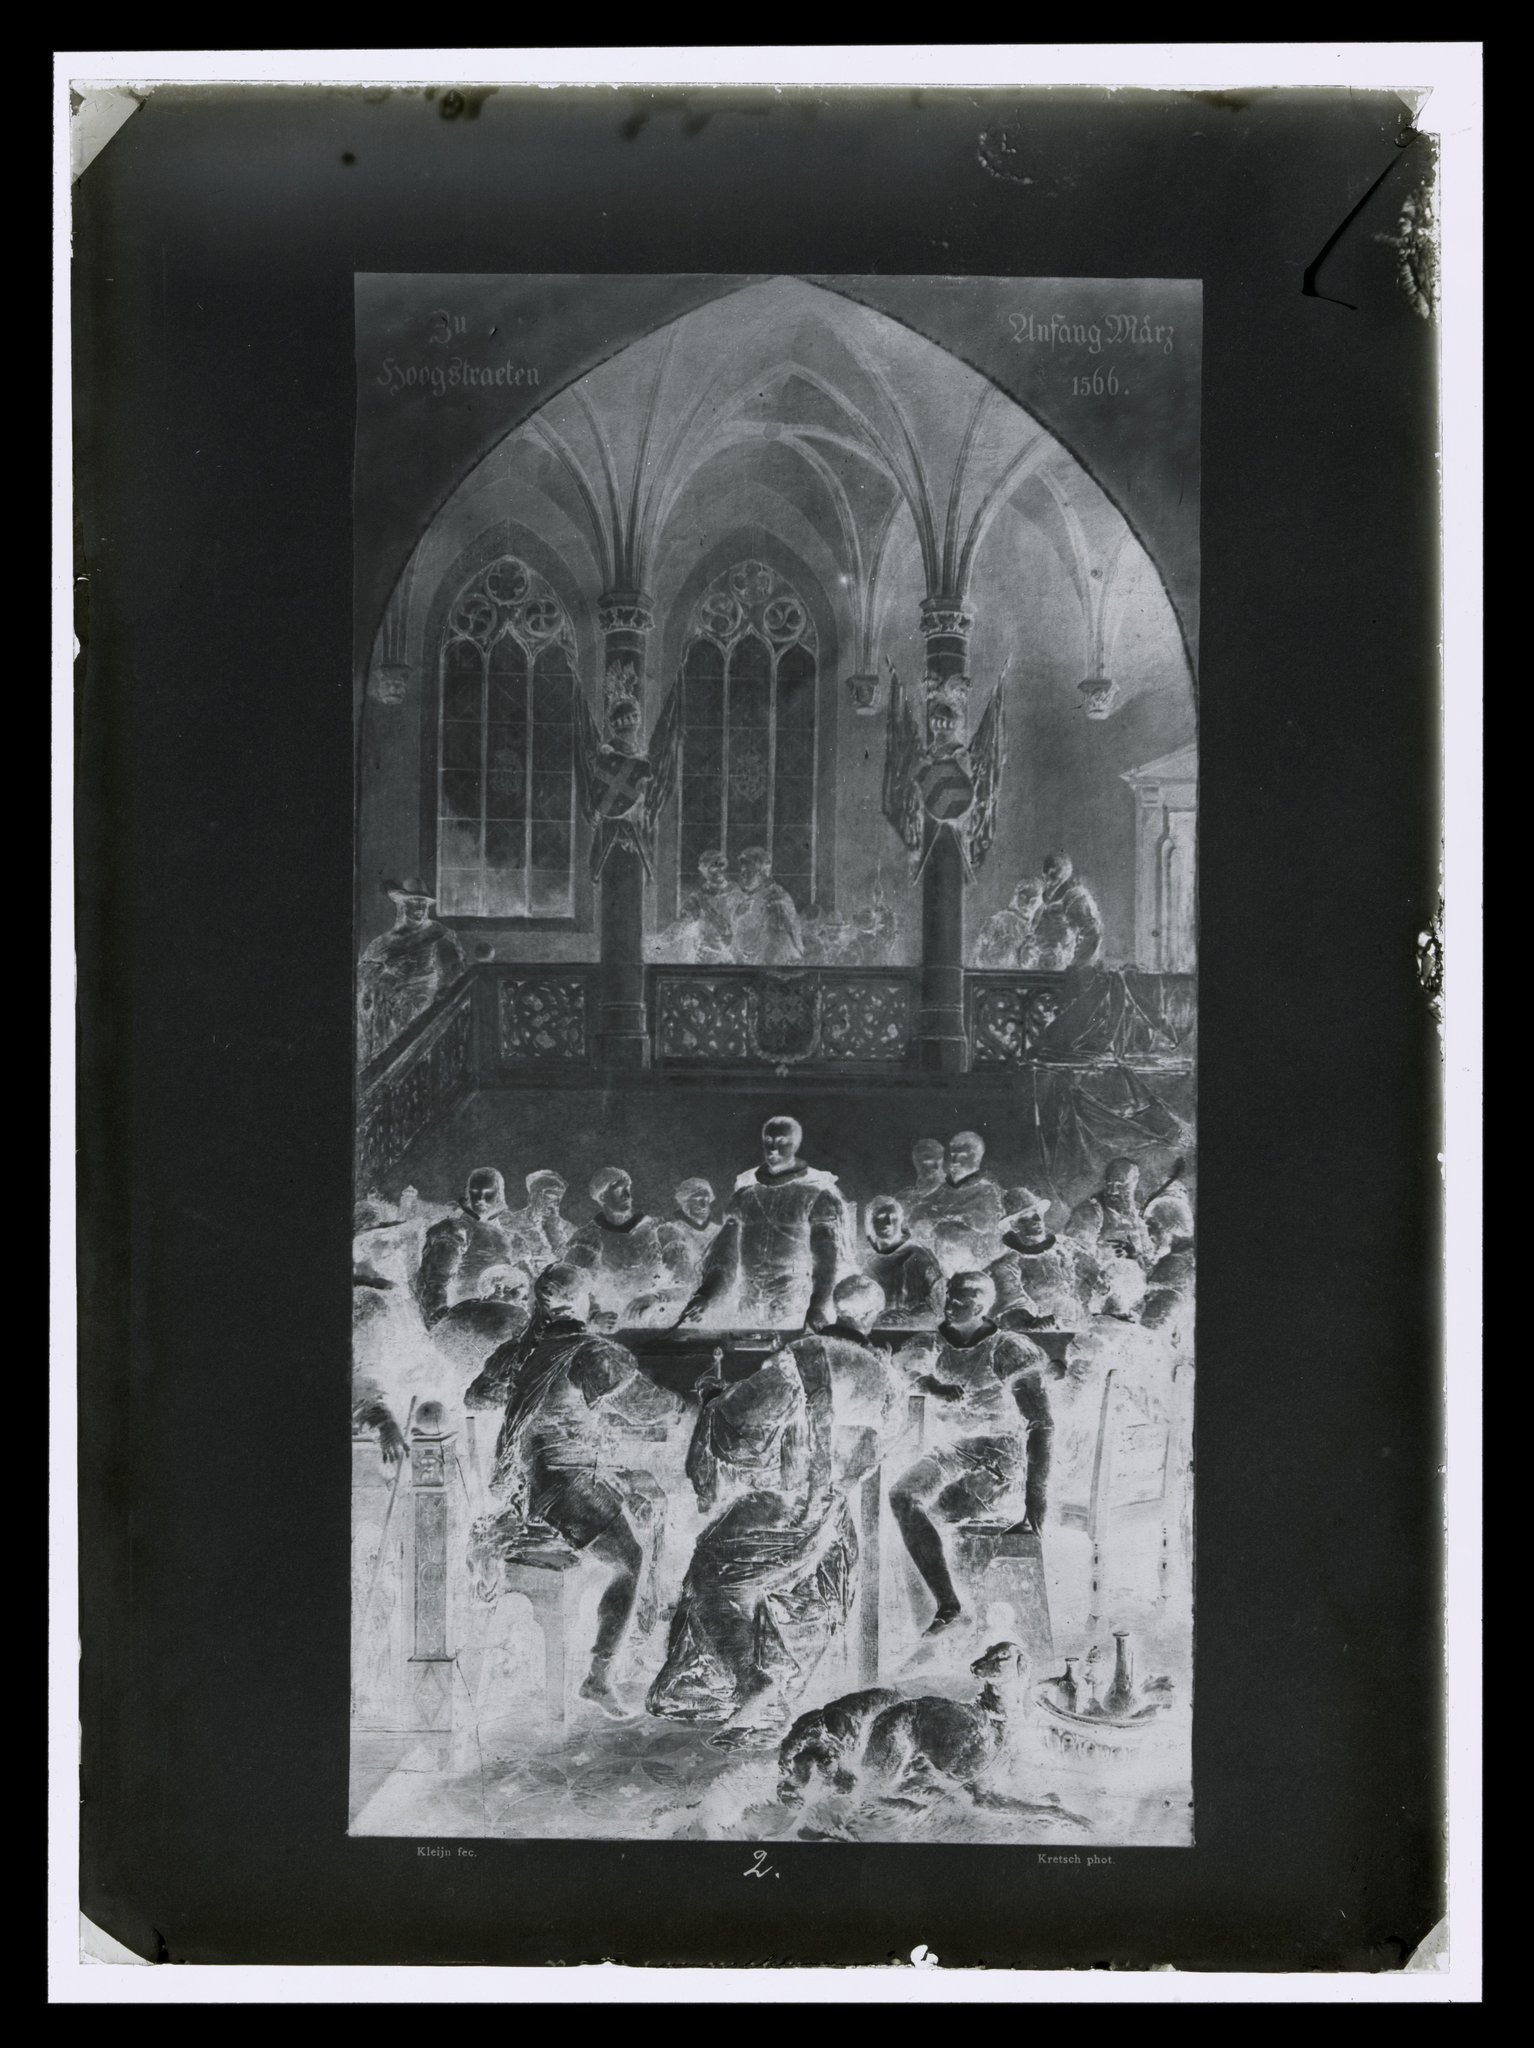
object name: reproduction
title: Zu Hoogstraeten, anfang Marz 1566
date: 1884-1900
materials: glass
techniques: collodion process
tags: debate, discussion (~ meeting)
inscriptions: number: ‘2.’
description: Onderdeel van een groep glasnegatieven uit de nalatenschap van de schilder Laurens Lodewijk Kleijn, met stillevens, portretten, zelfportretten en kunstreproducties.